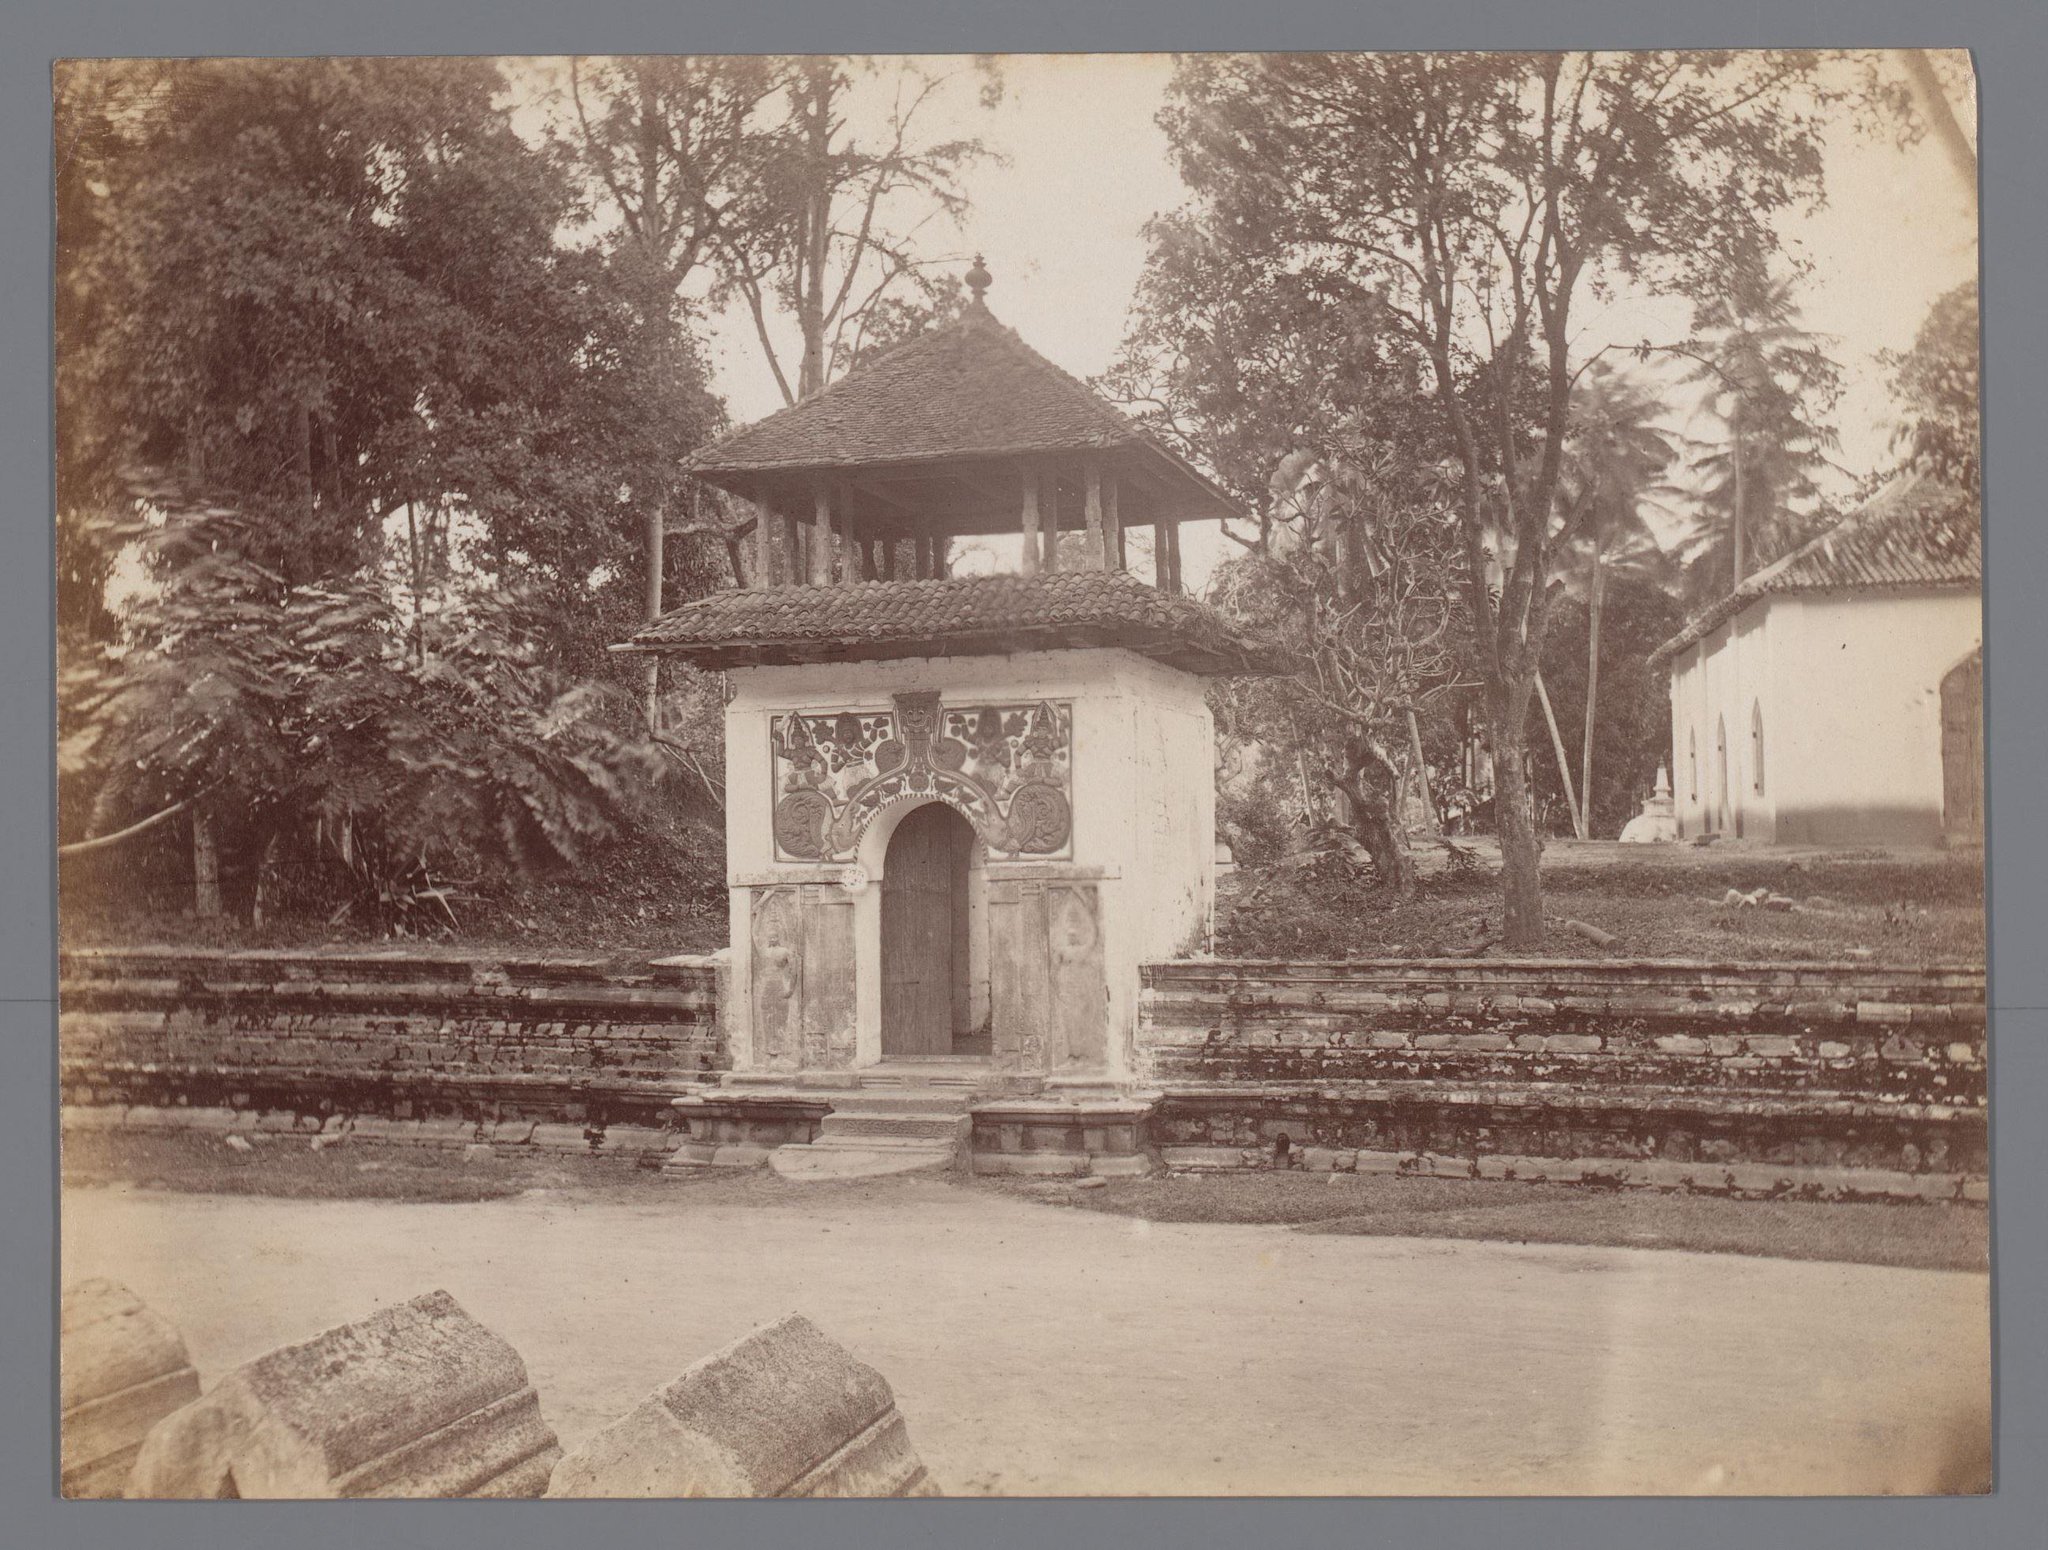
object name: photograph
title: Gate of a house with vegetation, Sri Lanka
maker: william louis henry skeen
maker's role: fotograaf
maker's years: 1847-1903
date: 1875-1910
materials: paper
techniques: albumen print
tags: sri lanka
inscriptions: inscription: ‘Gateway Entrance to [...]’, check stamp: ‘PHOTOGRAPHERS/ W.H.L.SKEEN&CO.’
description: Smal poortgebouw, met rechts deel van een huis omringd door vegetatie, Ceylon (?).